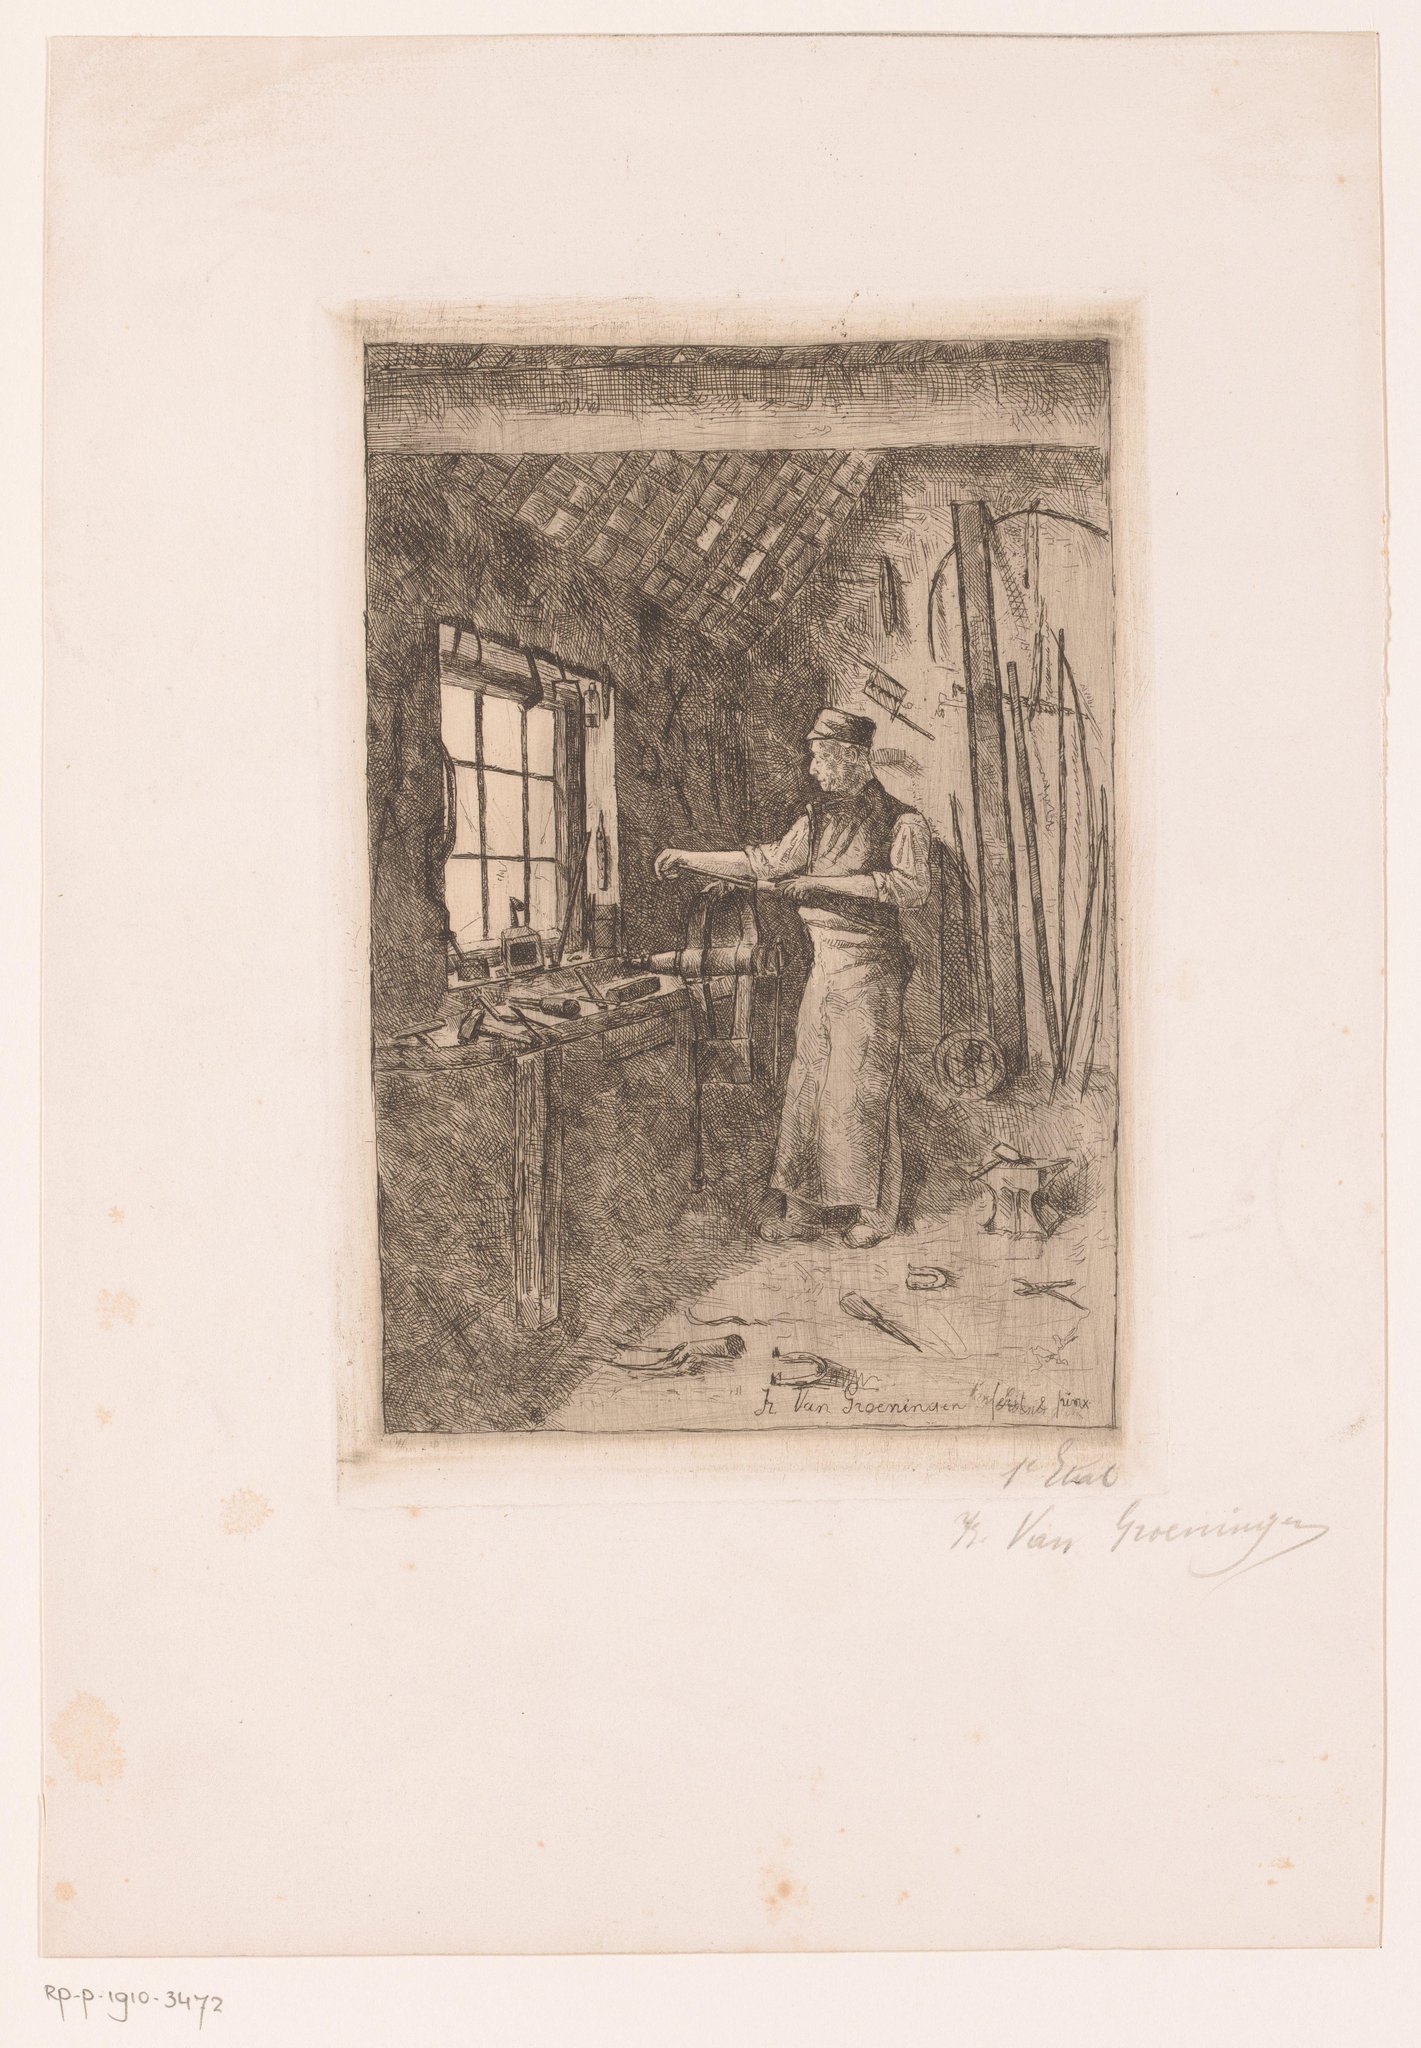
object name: print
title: Smid in zijn werkplaats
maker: fr. van groeningen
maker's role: print maker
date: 1850-1910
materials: paper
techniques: etching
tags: smith, blacksmith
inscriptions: collector's mark: Lugt 2228, annotation: ‘1e Etat’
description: Aangezien geboorte- en sterfdatum van de kunstenaar onbekend zijn, is voor de rechtenbepaling van dit object de verwervingsdatum gehanteerd.